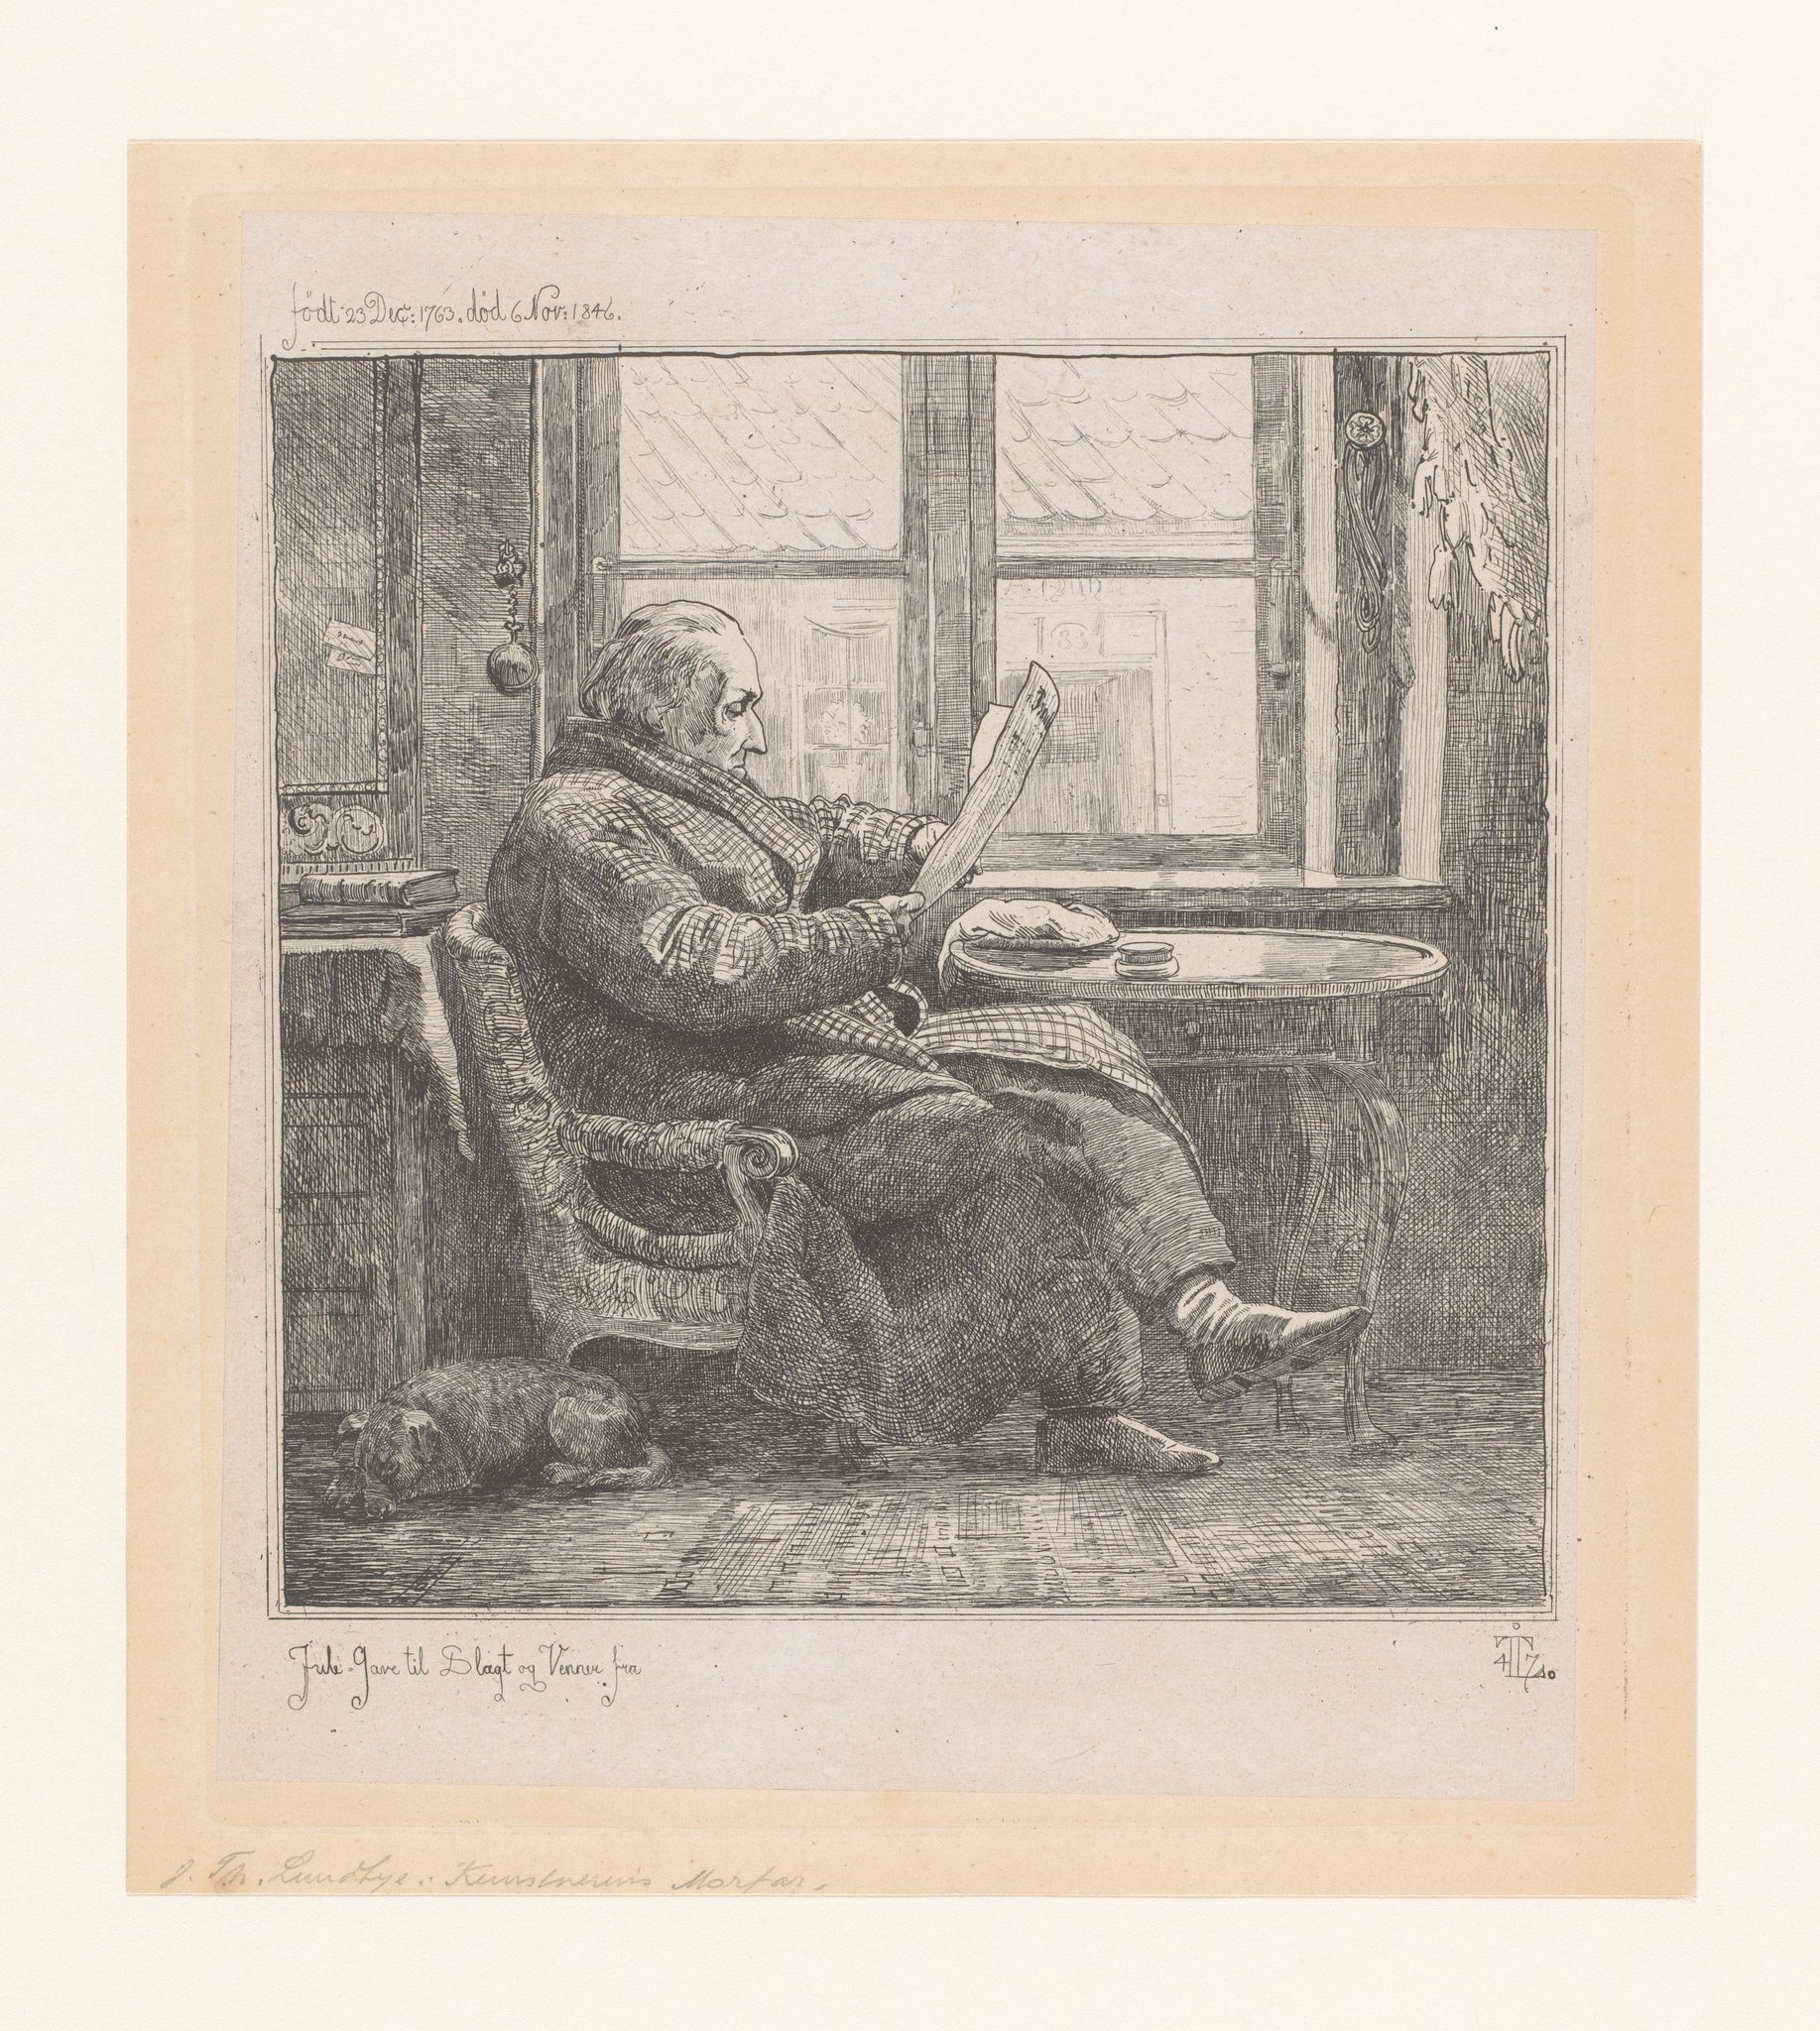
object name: print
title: Oude man leest de krant bij het raam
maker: johan thomas lundbye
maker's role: print maker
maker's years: 1818-1848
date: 1847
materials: paper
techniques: etching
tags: reading, newspaper, news-sheet, dog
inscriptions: collector's mark: Lugt 2760, collector's mark: Lugt 2228